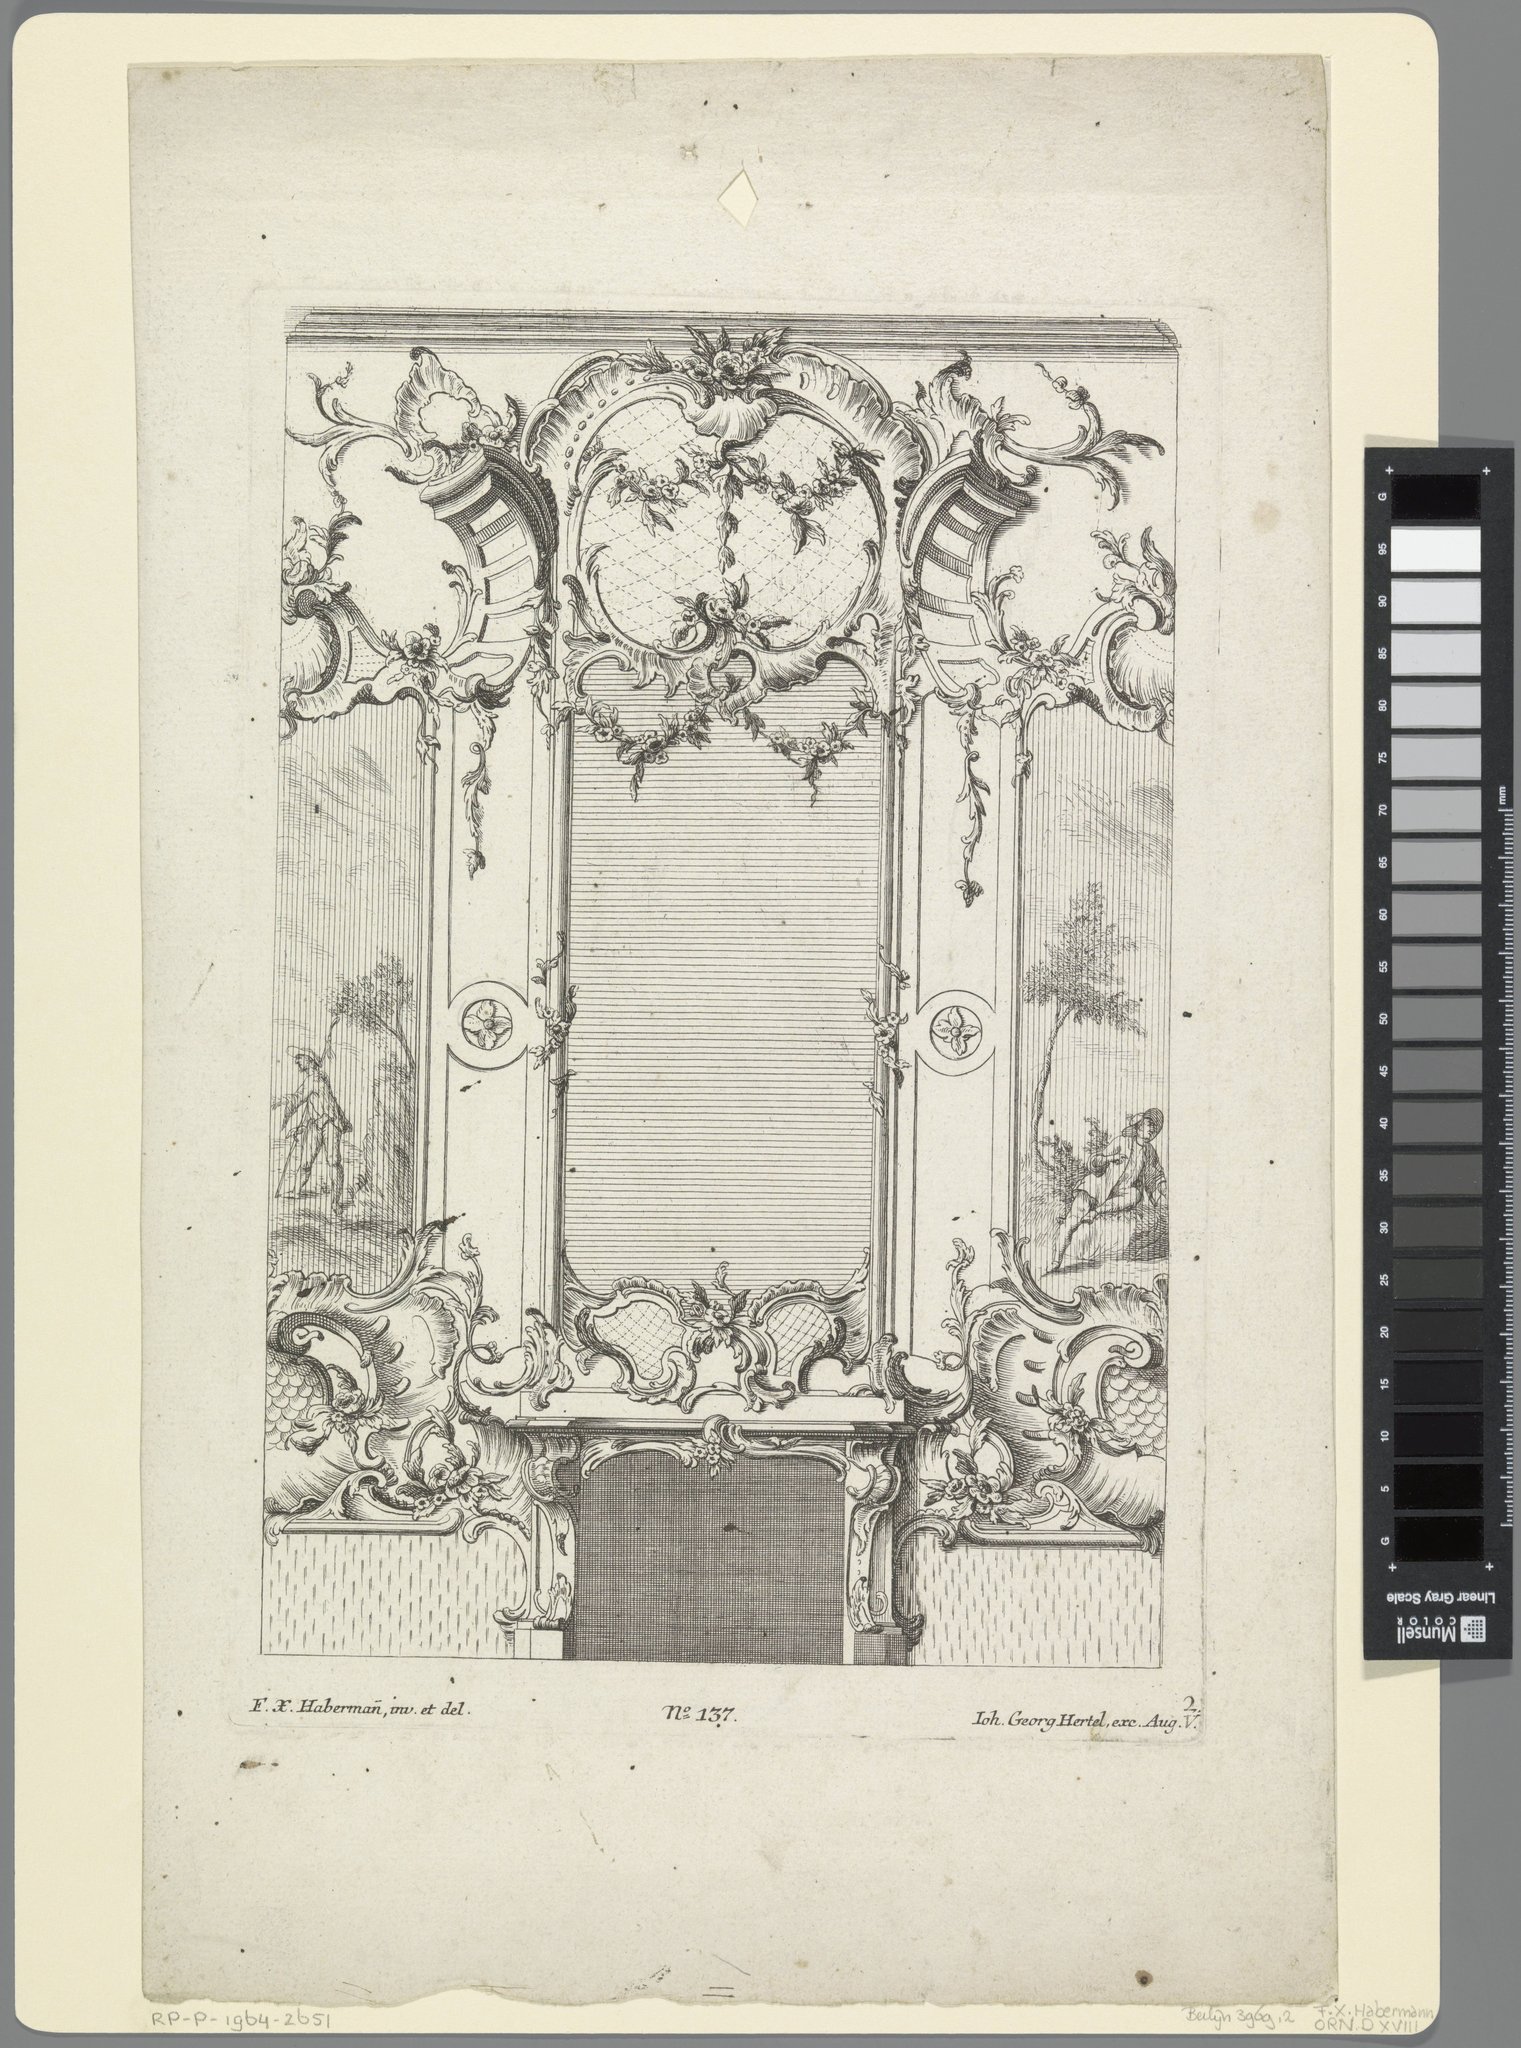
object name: print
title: Wandindelingen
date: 1748-1753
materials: paper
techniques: engraving, etching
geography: augsburg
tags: rocaille ornament, panelling, open hearth, fire-place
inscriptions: collector's mark: Lugt 2760, collector's mark: Lugt 2228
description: Wandindeling met een schouw en drie panelen met rocaille omlijstingen. De twee panelen links en rechts met pastorale scènes zijn voor de helft zichtbaar. Uitgeversnummer 137.